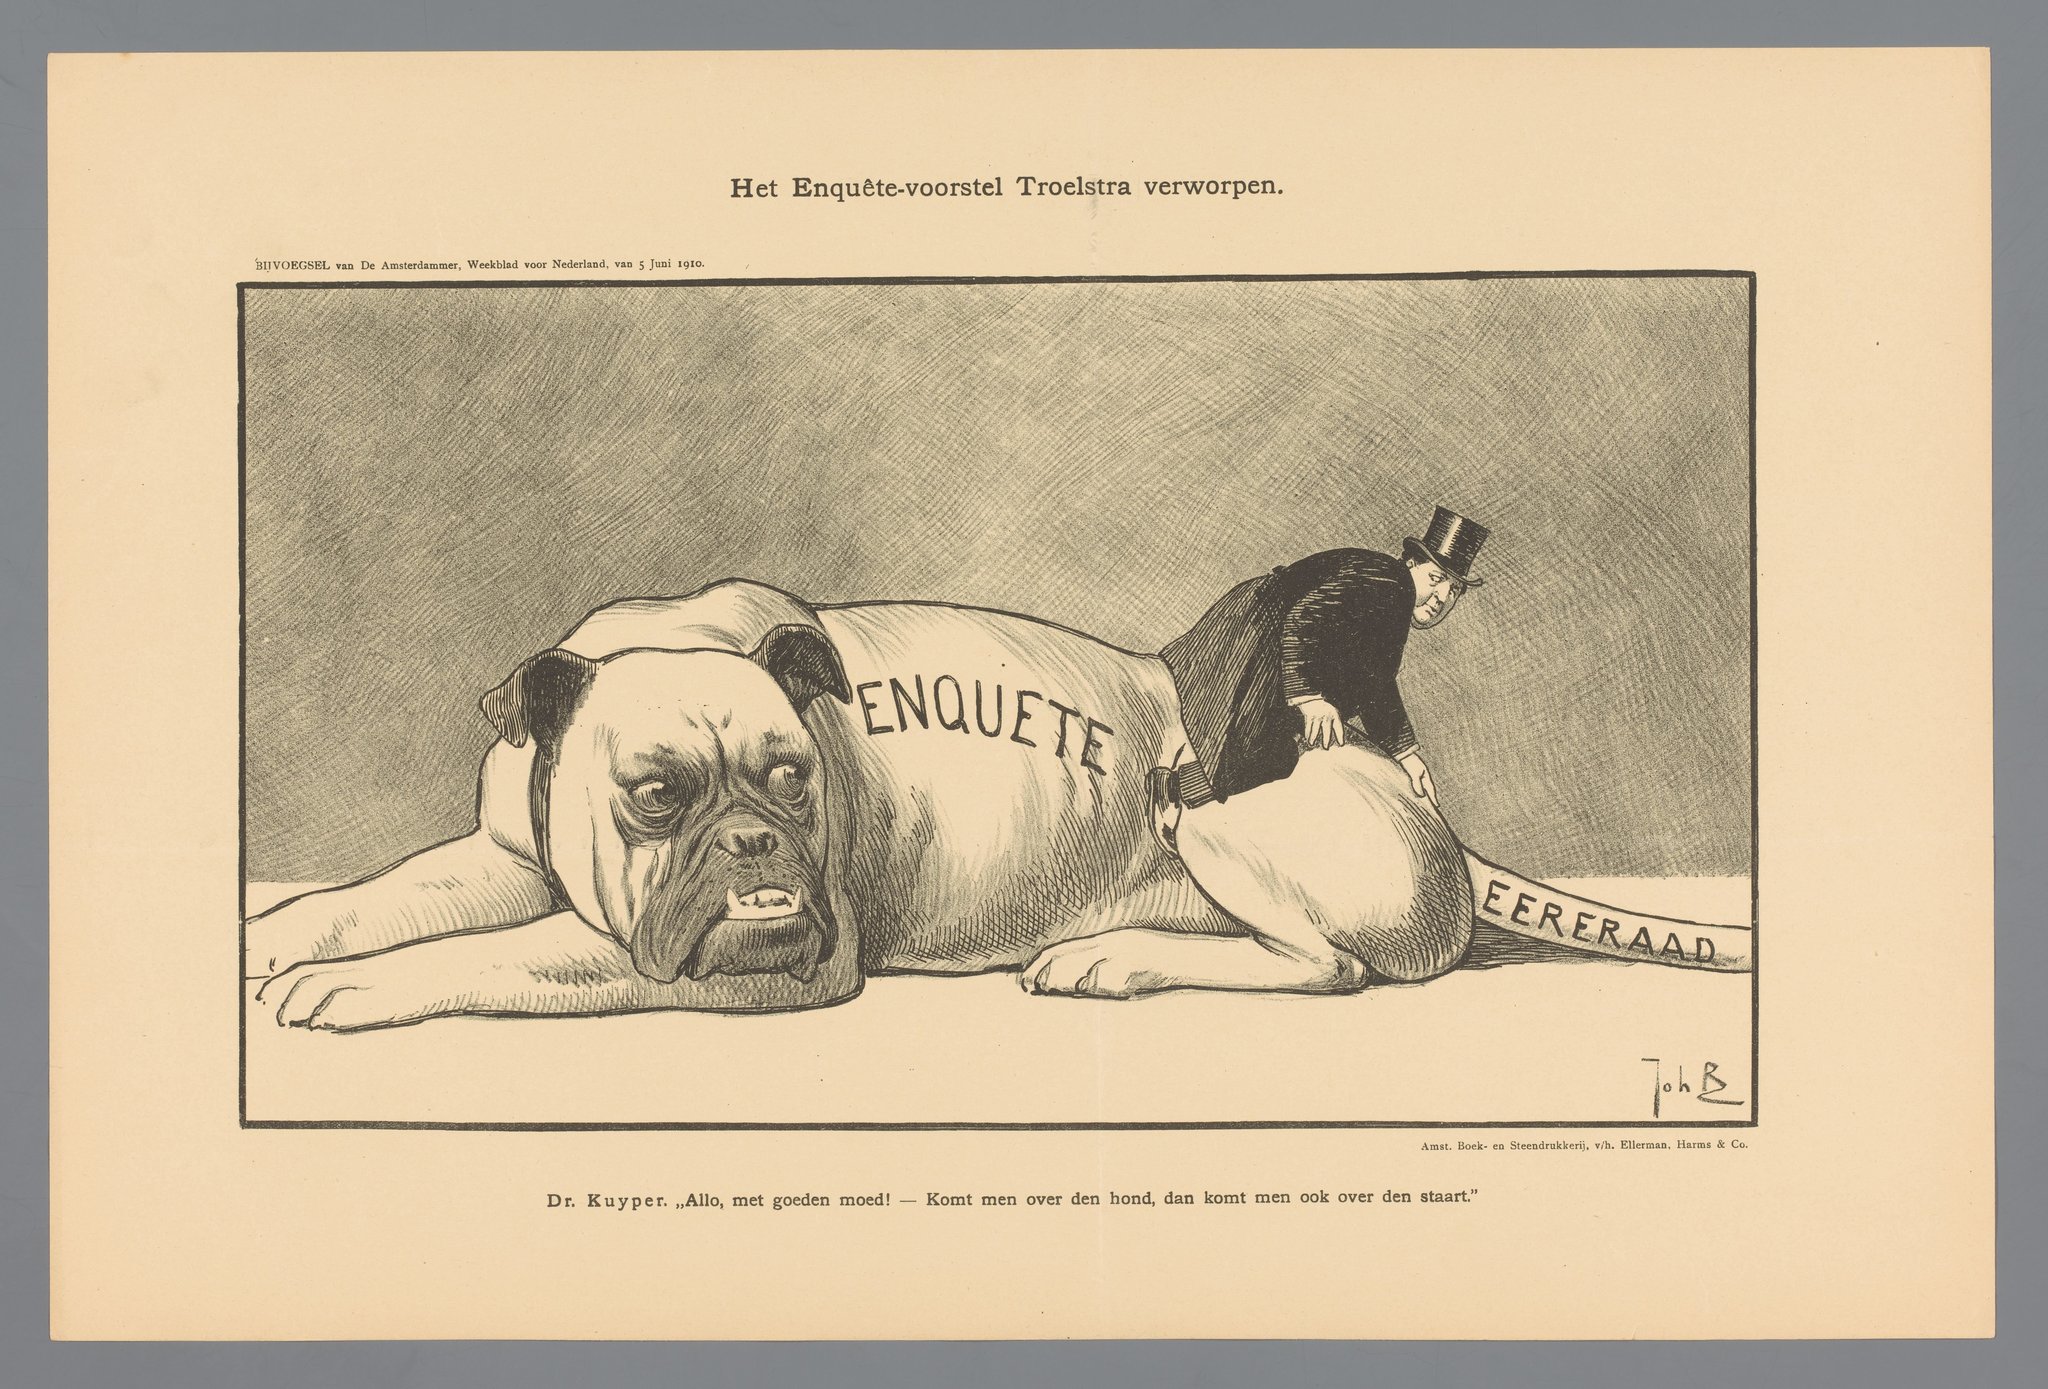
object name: cartoon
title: Het Enquête-Voorstel Troelstra verworpen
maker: johan braakensiek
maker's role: draughtsman, print maker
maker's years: 1858-1940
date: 1910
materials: paper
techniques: lithograph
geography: amsterdam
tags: politician, the hague, abraham kuyper, historical persons, political caricatures and satires, dog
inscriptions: date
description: Prent uit het bijvoegsel van: De Amsterdammer. Weekblad voor Nederland, 5 juni 1910.